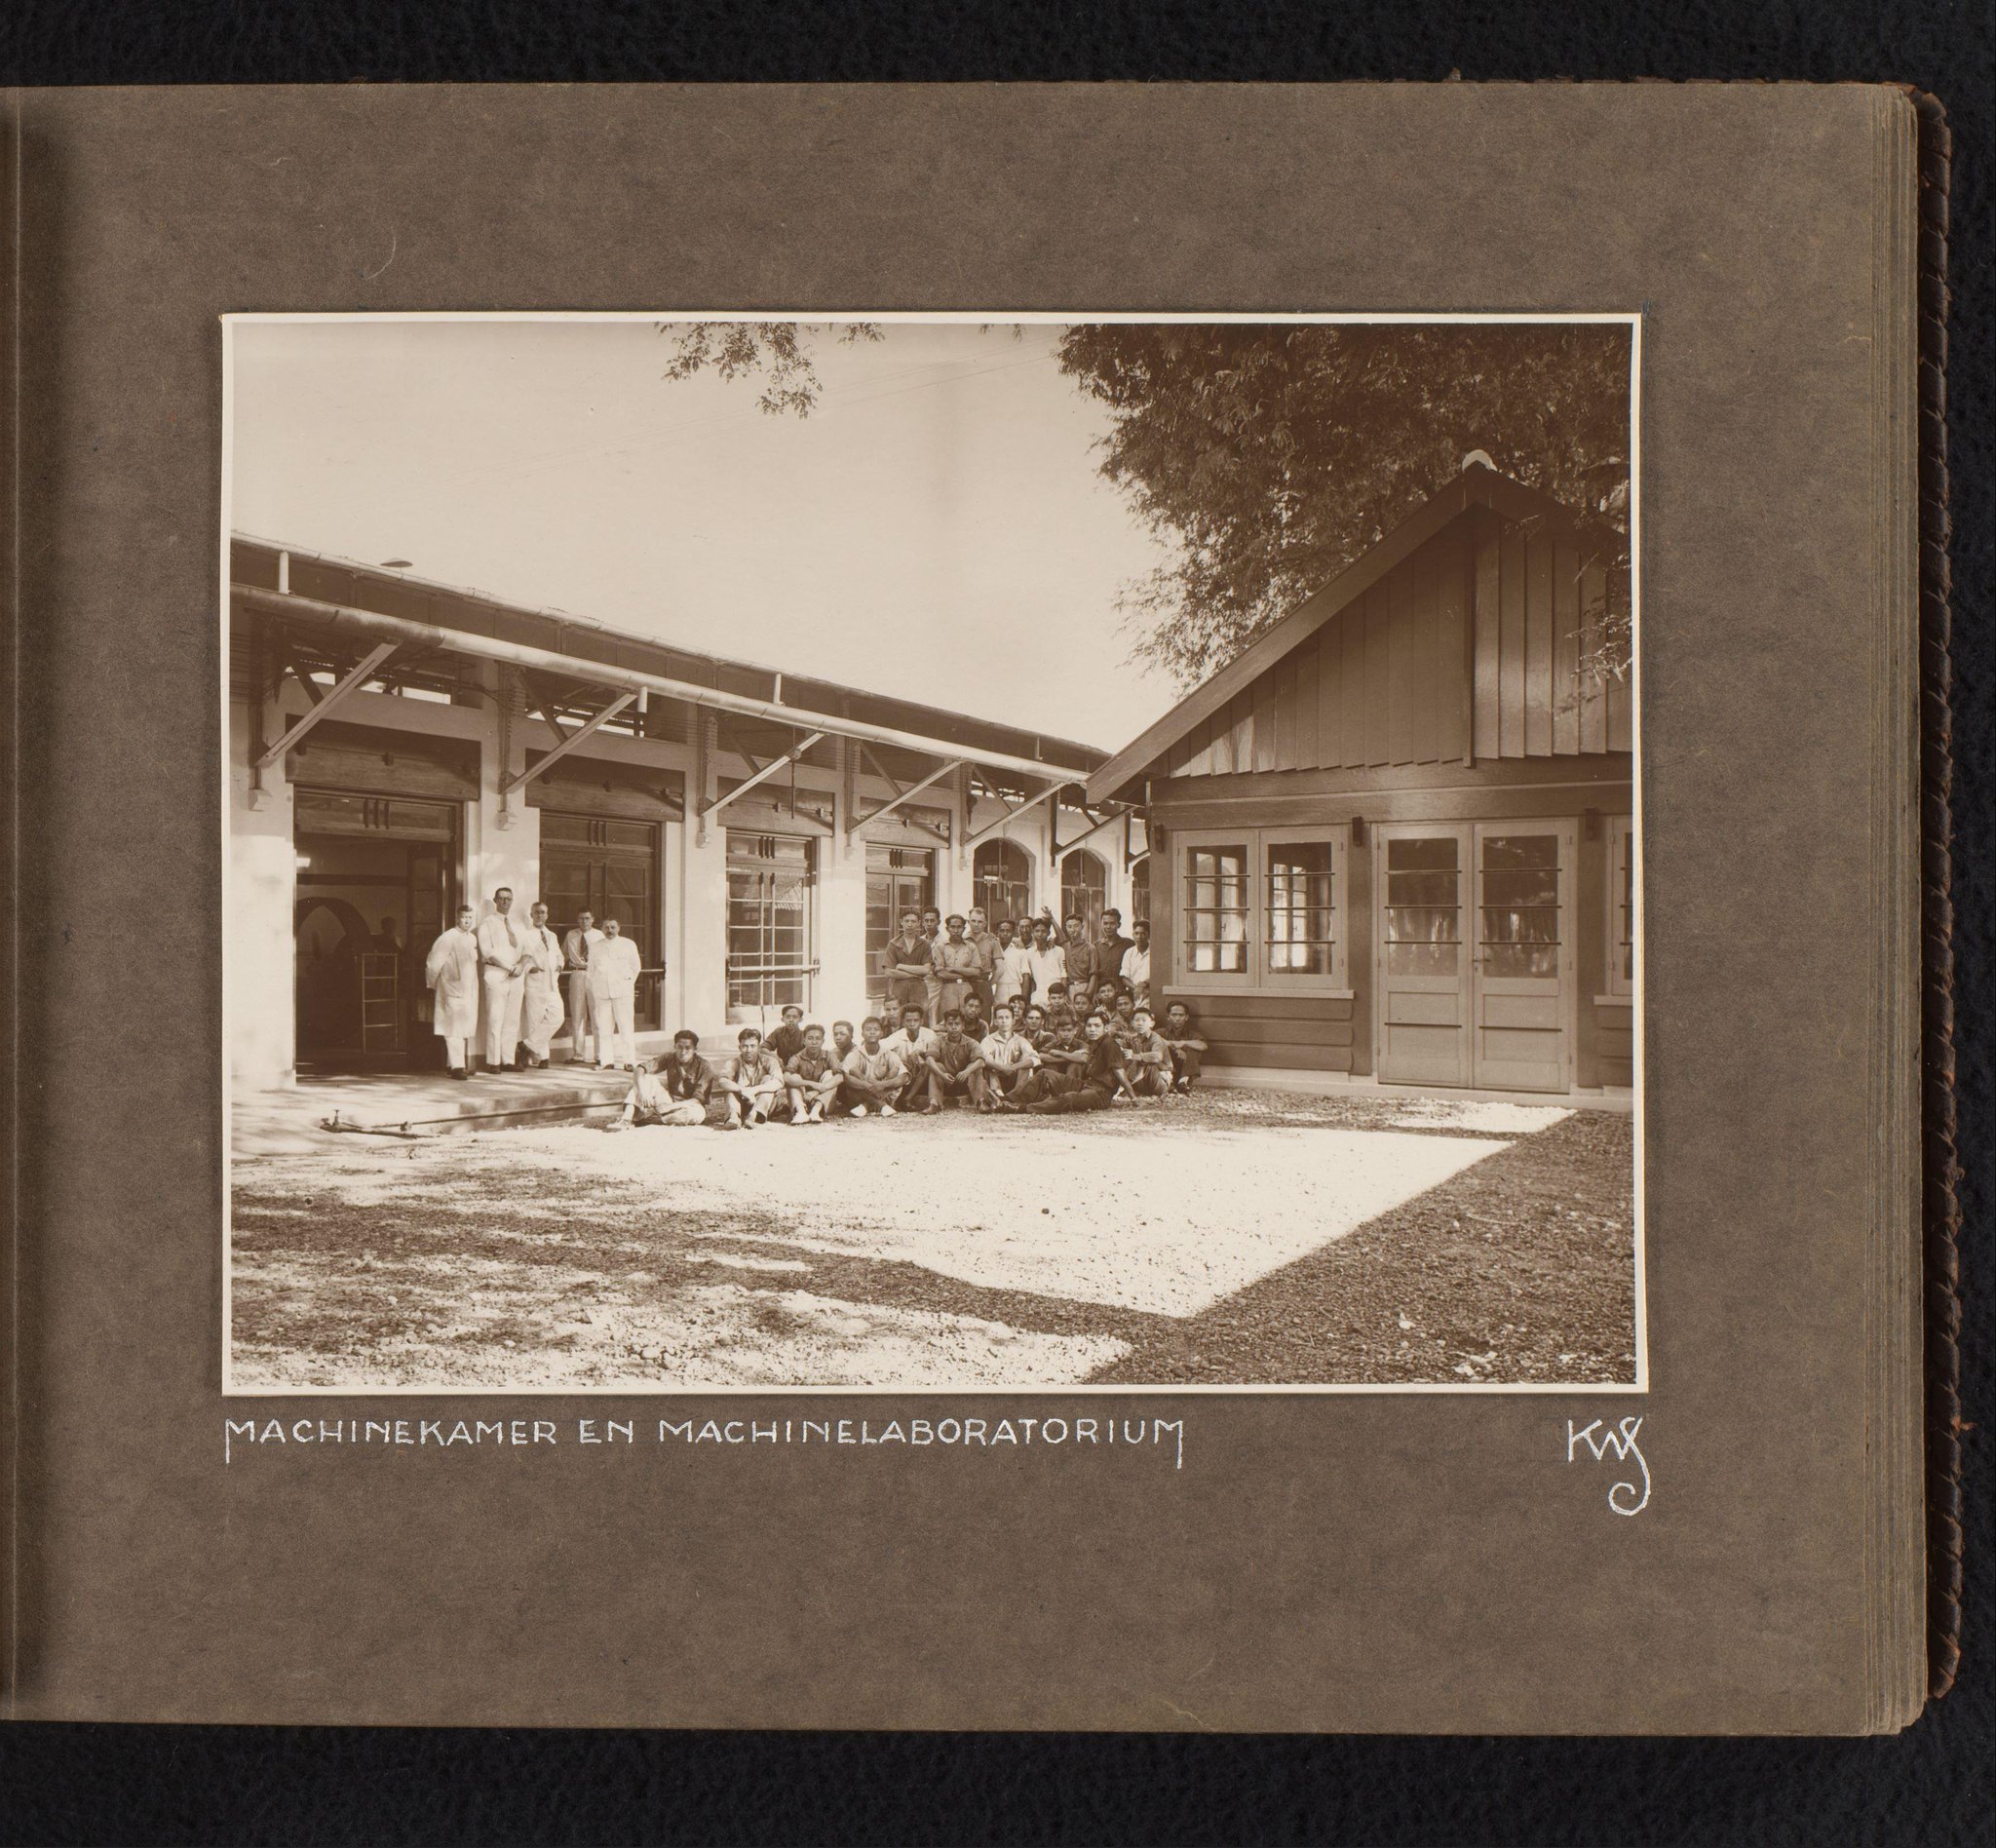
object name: photograph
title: Machinekamer en Machinelaboratorium op de Koningin Wilhelmina School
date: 1933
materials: photographic support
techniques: gelatin silver print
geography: batavia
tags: vocational education, e.g.: junior technical school, colonial government, dutch east indies, the, batavia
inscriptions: inscription: ‘Machinekamer en Machinelaboratorium / KWS’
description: Machinekamer en Machinelaboratorium op de Koningin Wilhelmina School te Batavia. Groepsfoto van docenten en leerlingen poserend buiten voor de werkplaats. Foto ingeplakt in het fotoalbum aangeboden aan J.H.A. van der Hoeven bij het beëindigen op 31 juli 1933 van zijn diensttijd bij het Nijverheidsonderwijs in Nederlandsch-Indië.